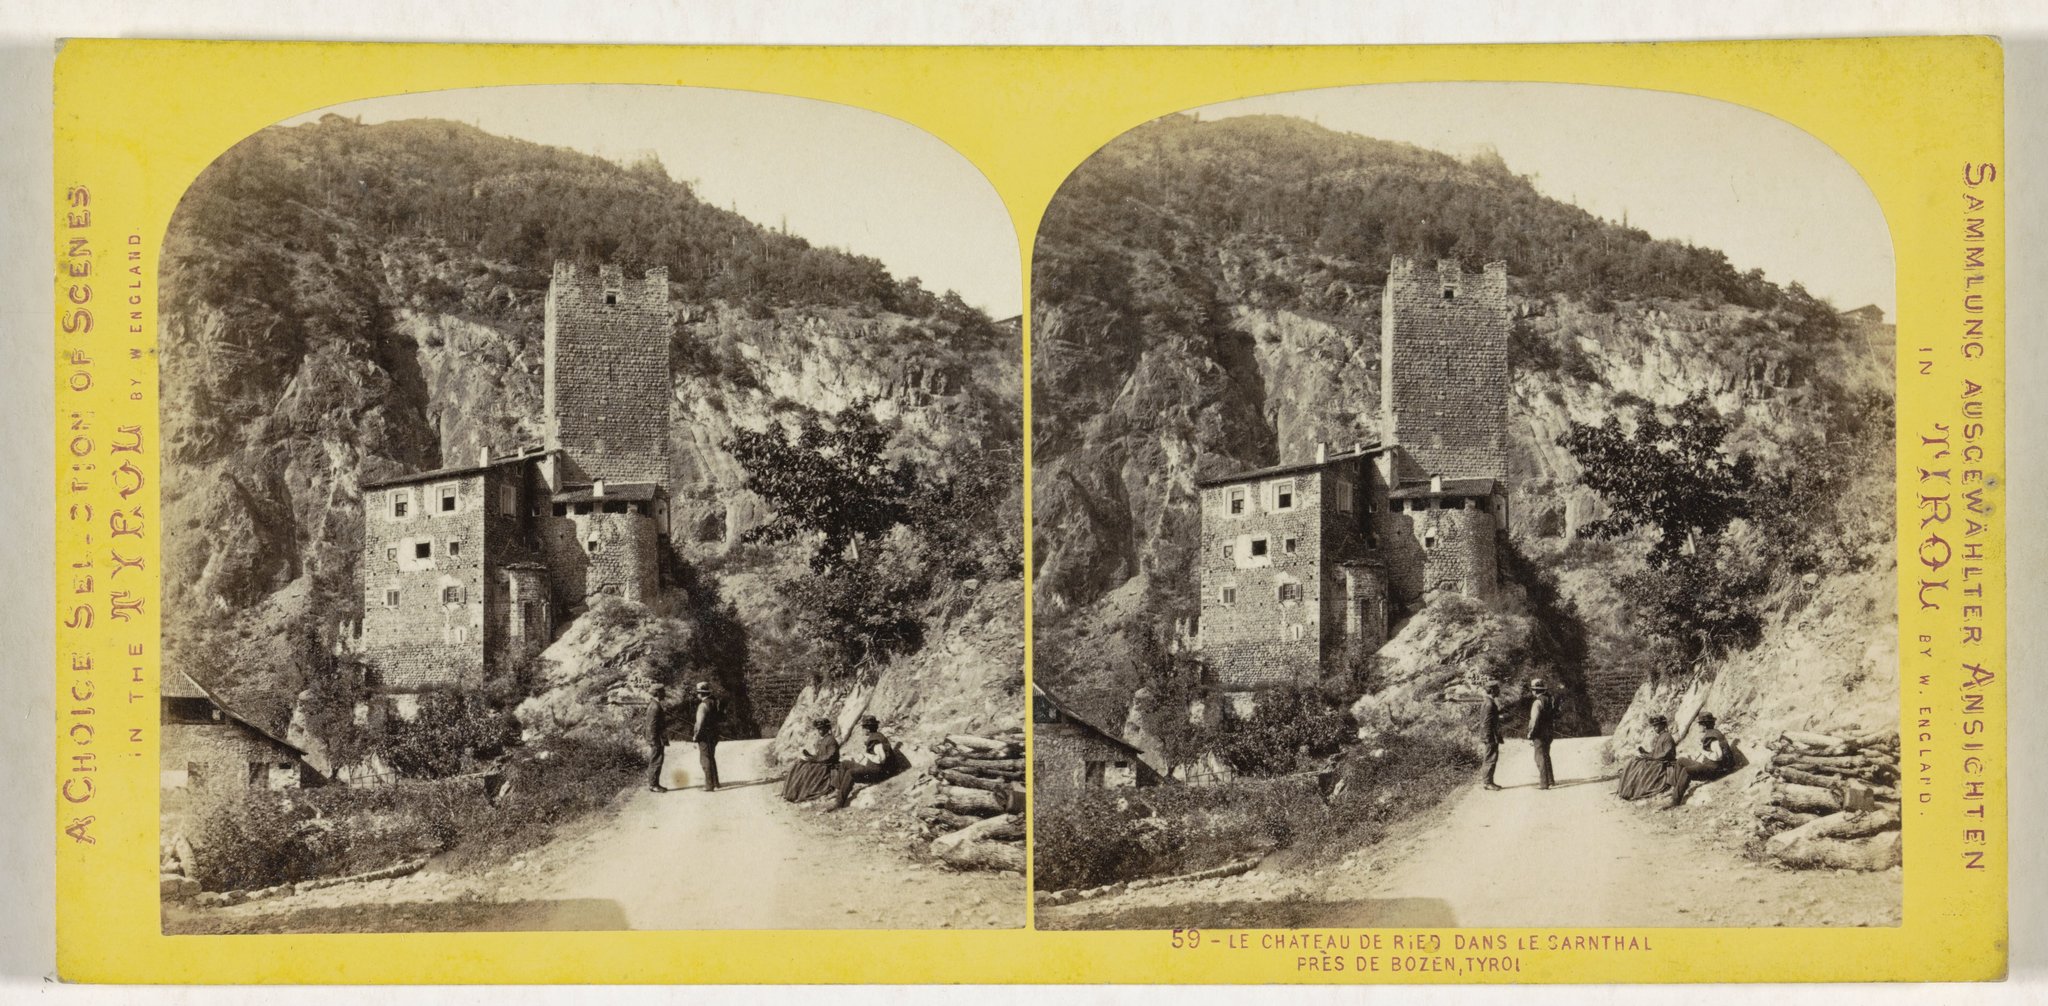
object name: stereograph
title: Slot Ried nabij Bolzano, Zuid-Tirol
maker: william england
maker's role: fotograaf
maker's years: 1816-1896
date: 1863-1865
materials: cardboard, paper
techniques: albumen print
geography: south tyrol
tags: castle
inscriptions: number: ‘59’